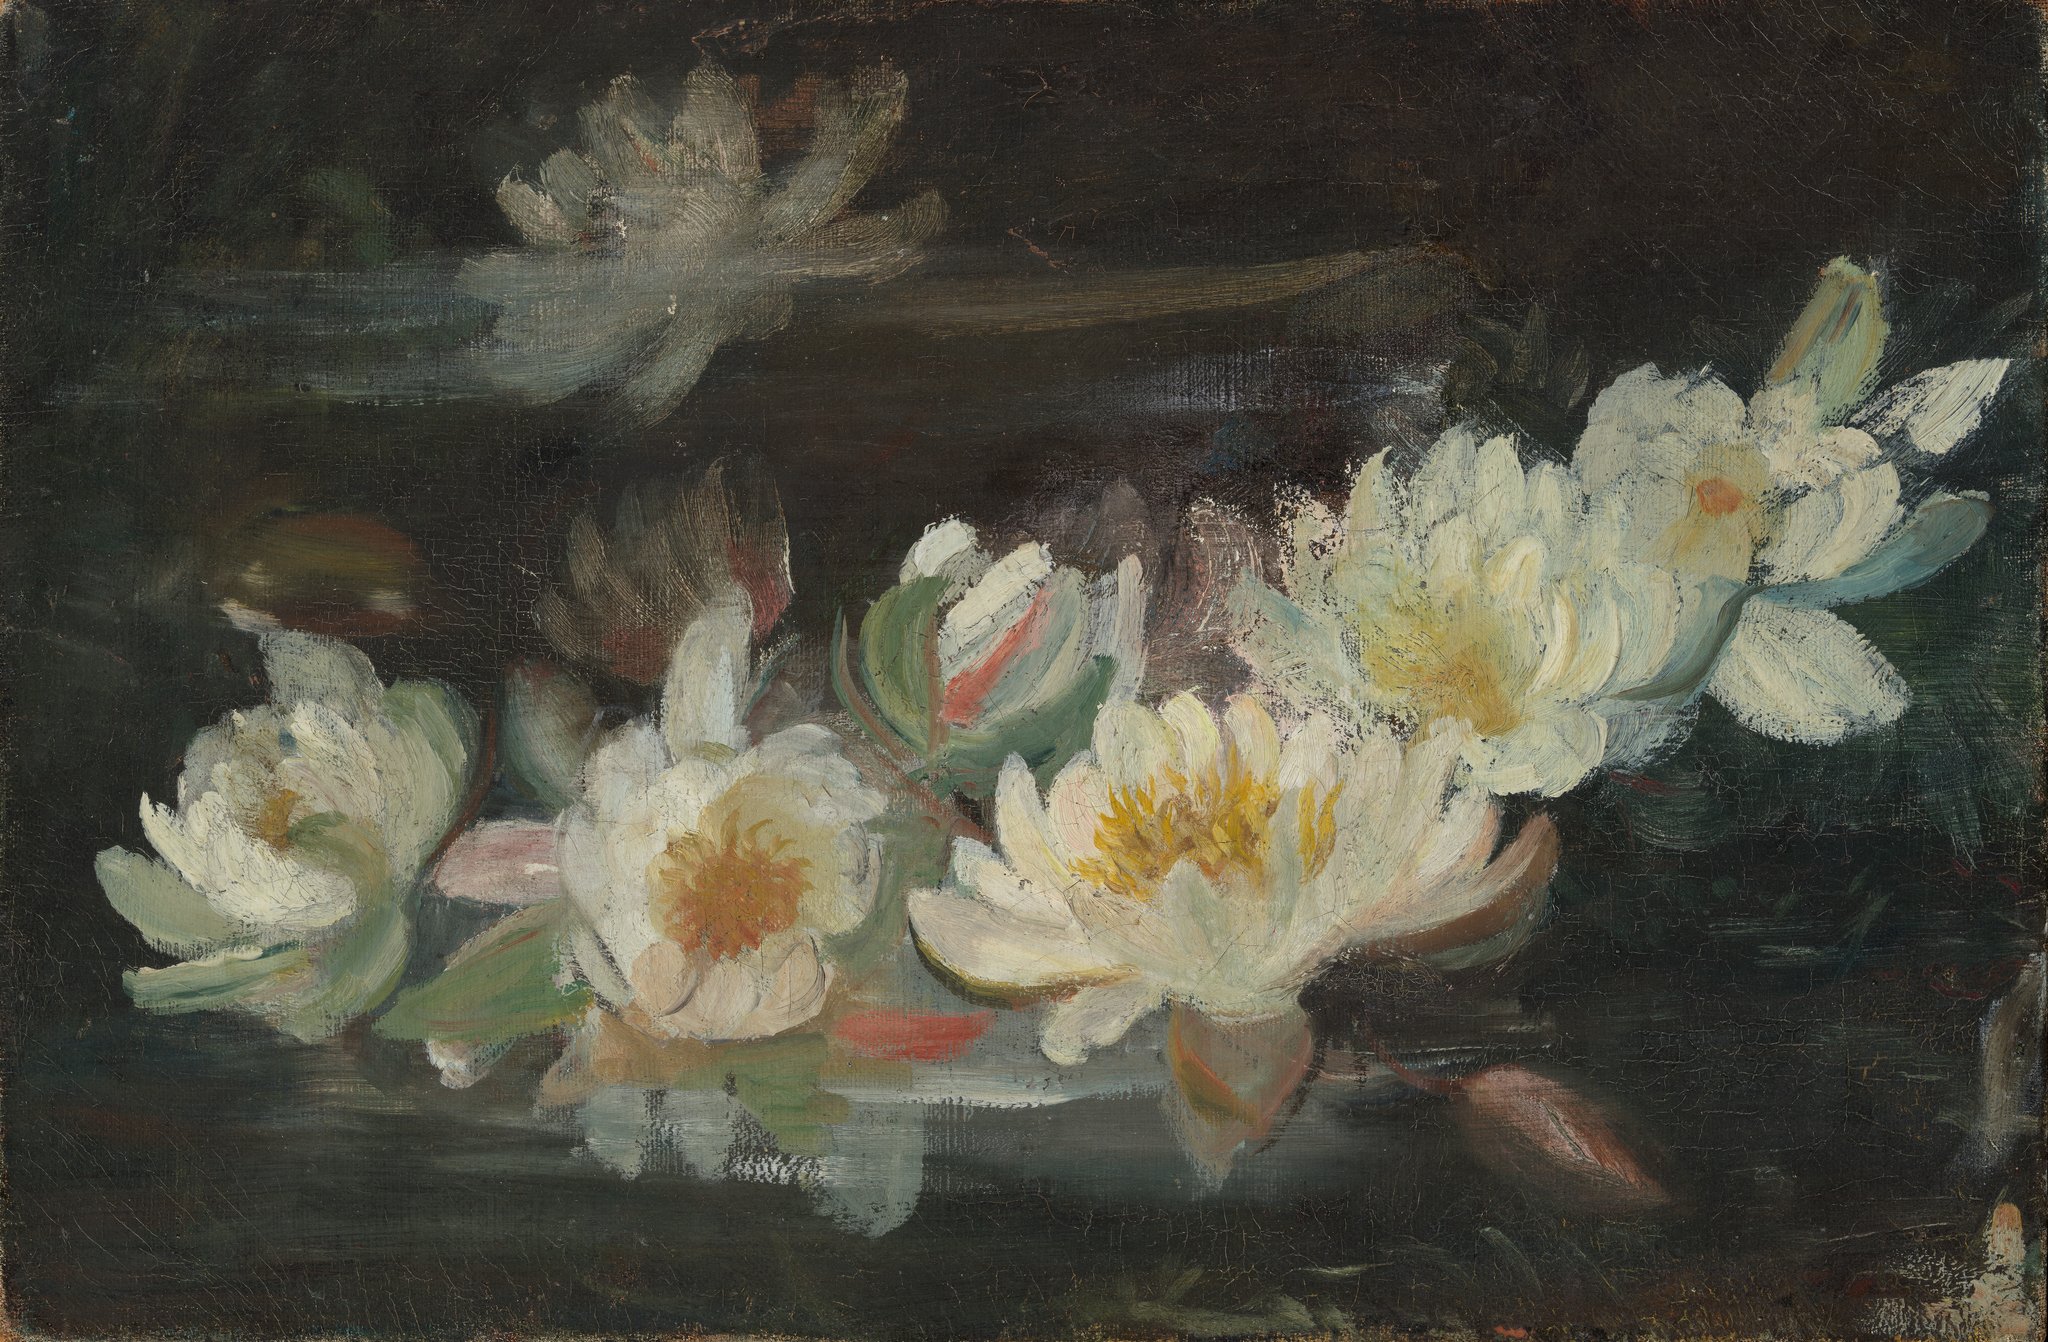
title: Water Lilies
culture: american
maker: helena de kay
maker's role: artist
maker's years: 1846-1916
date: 1870-1877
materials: canvas, oil